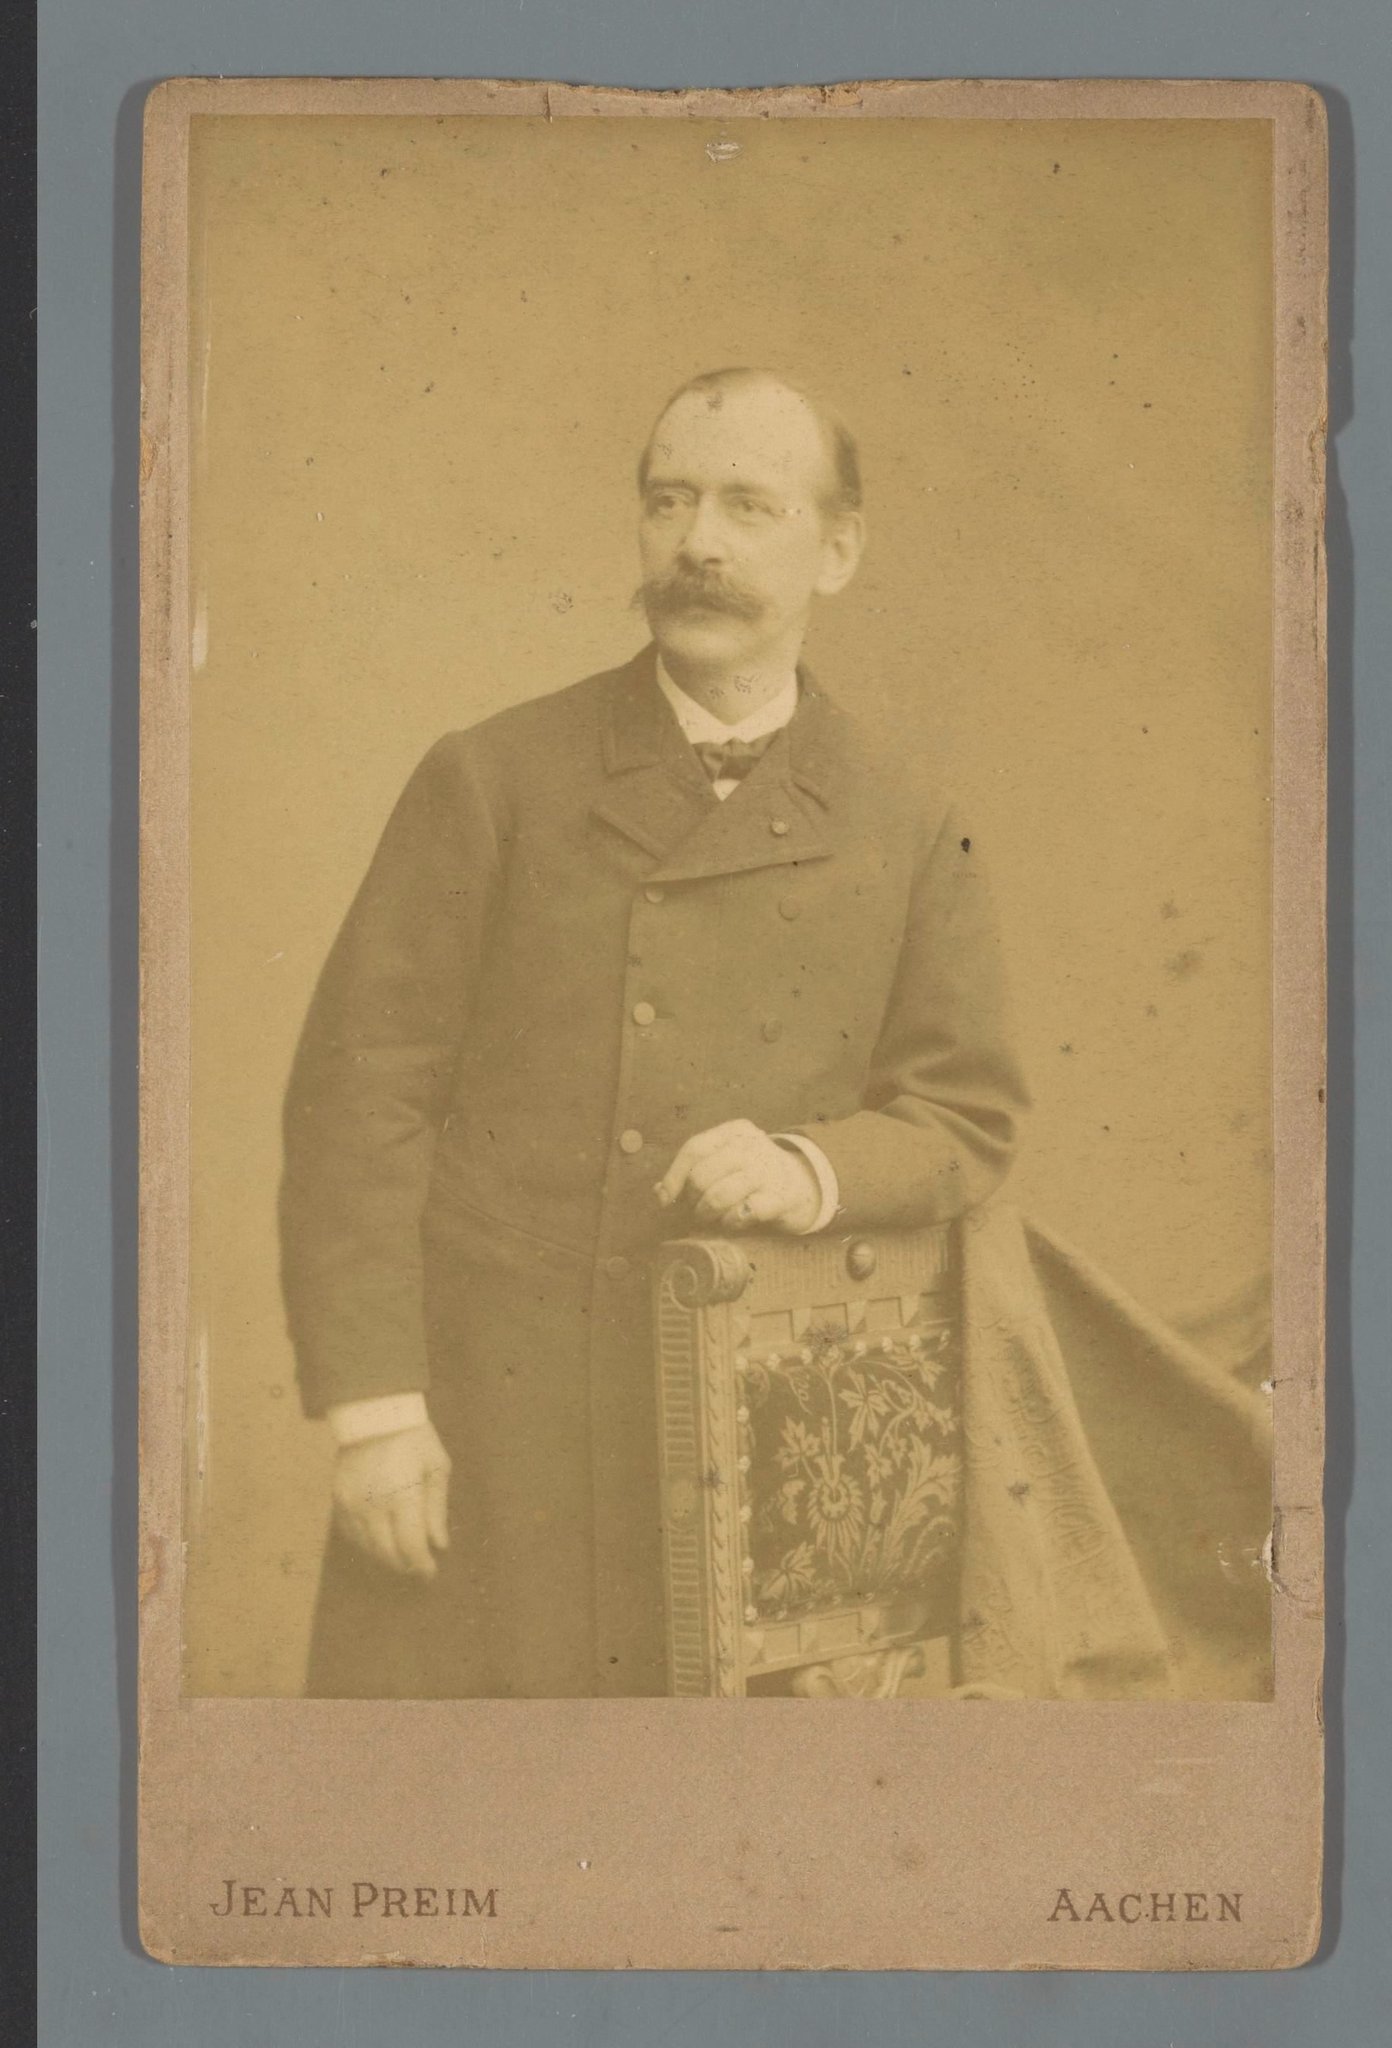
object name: carte de visite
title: Portret van Edouard Mussche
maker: jean preim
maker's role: fotograaf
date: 1875-1880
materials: cardboard, photographic support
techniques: albumen print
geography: aachen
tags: historical persons